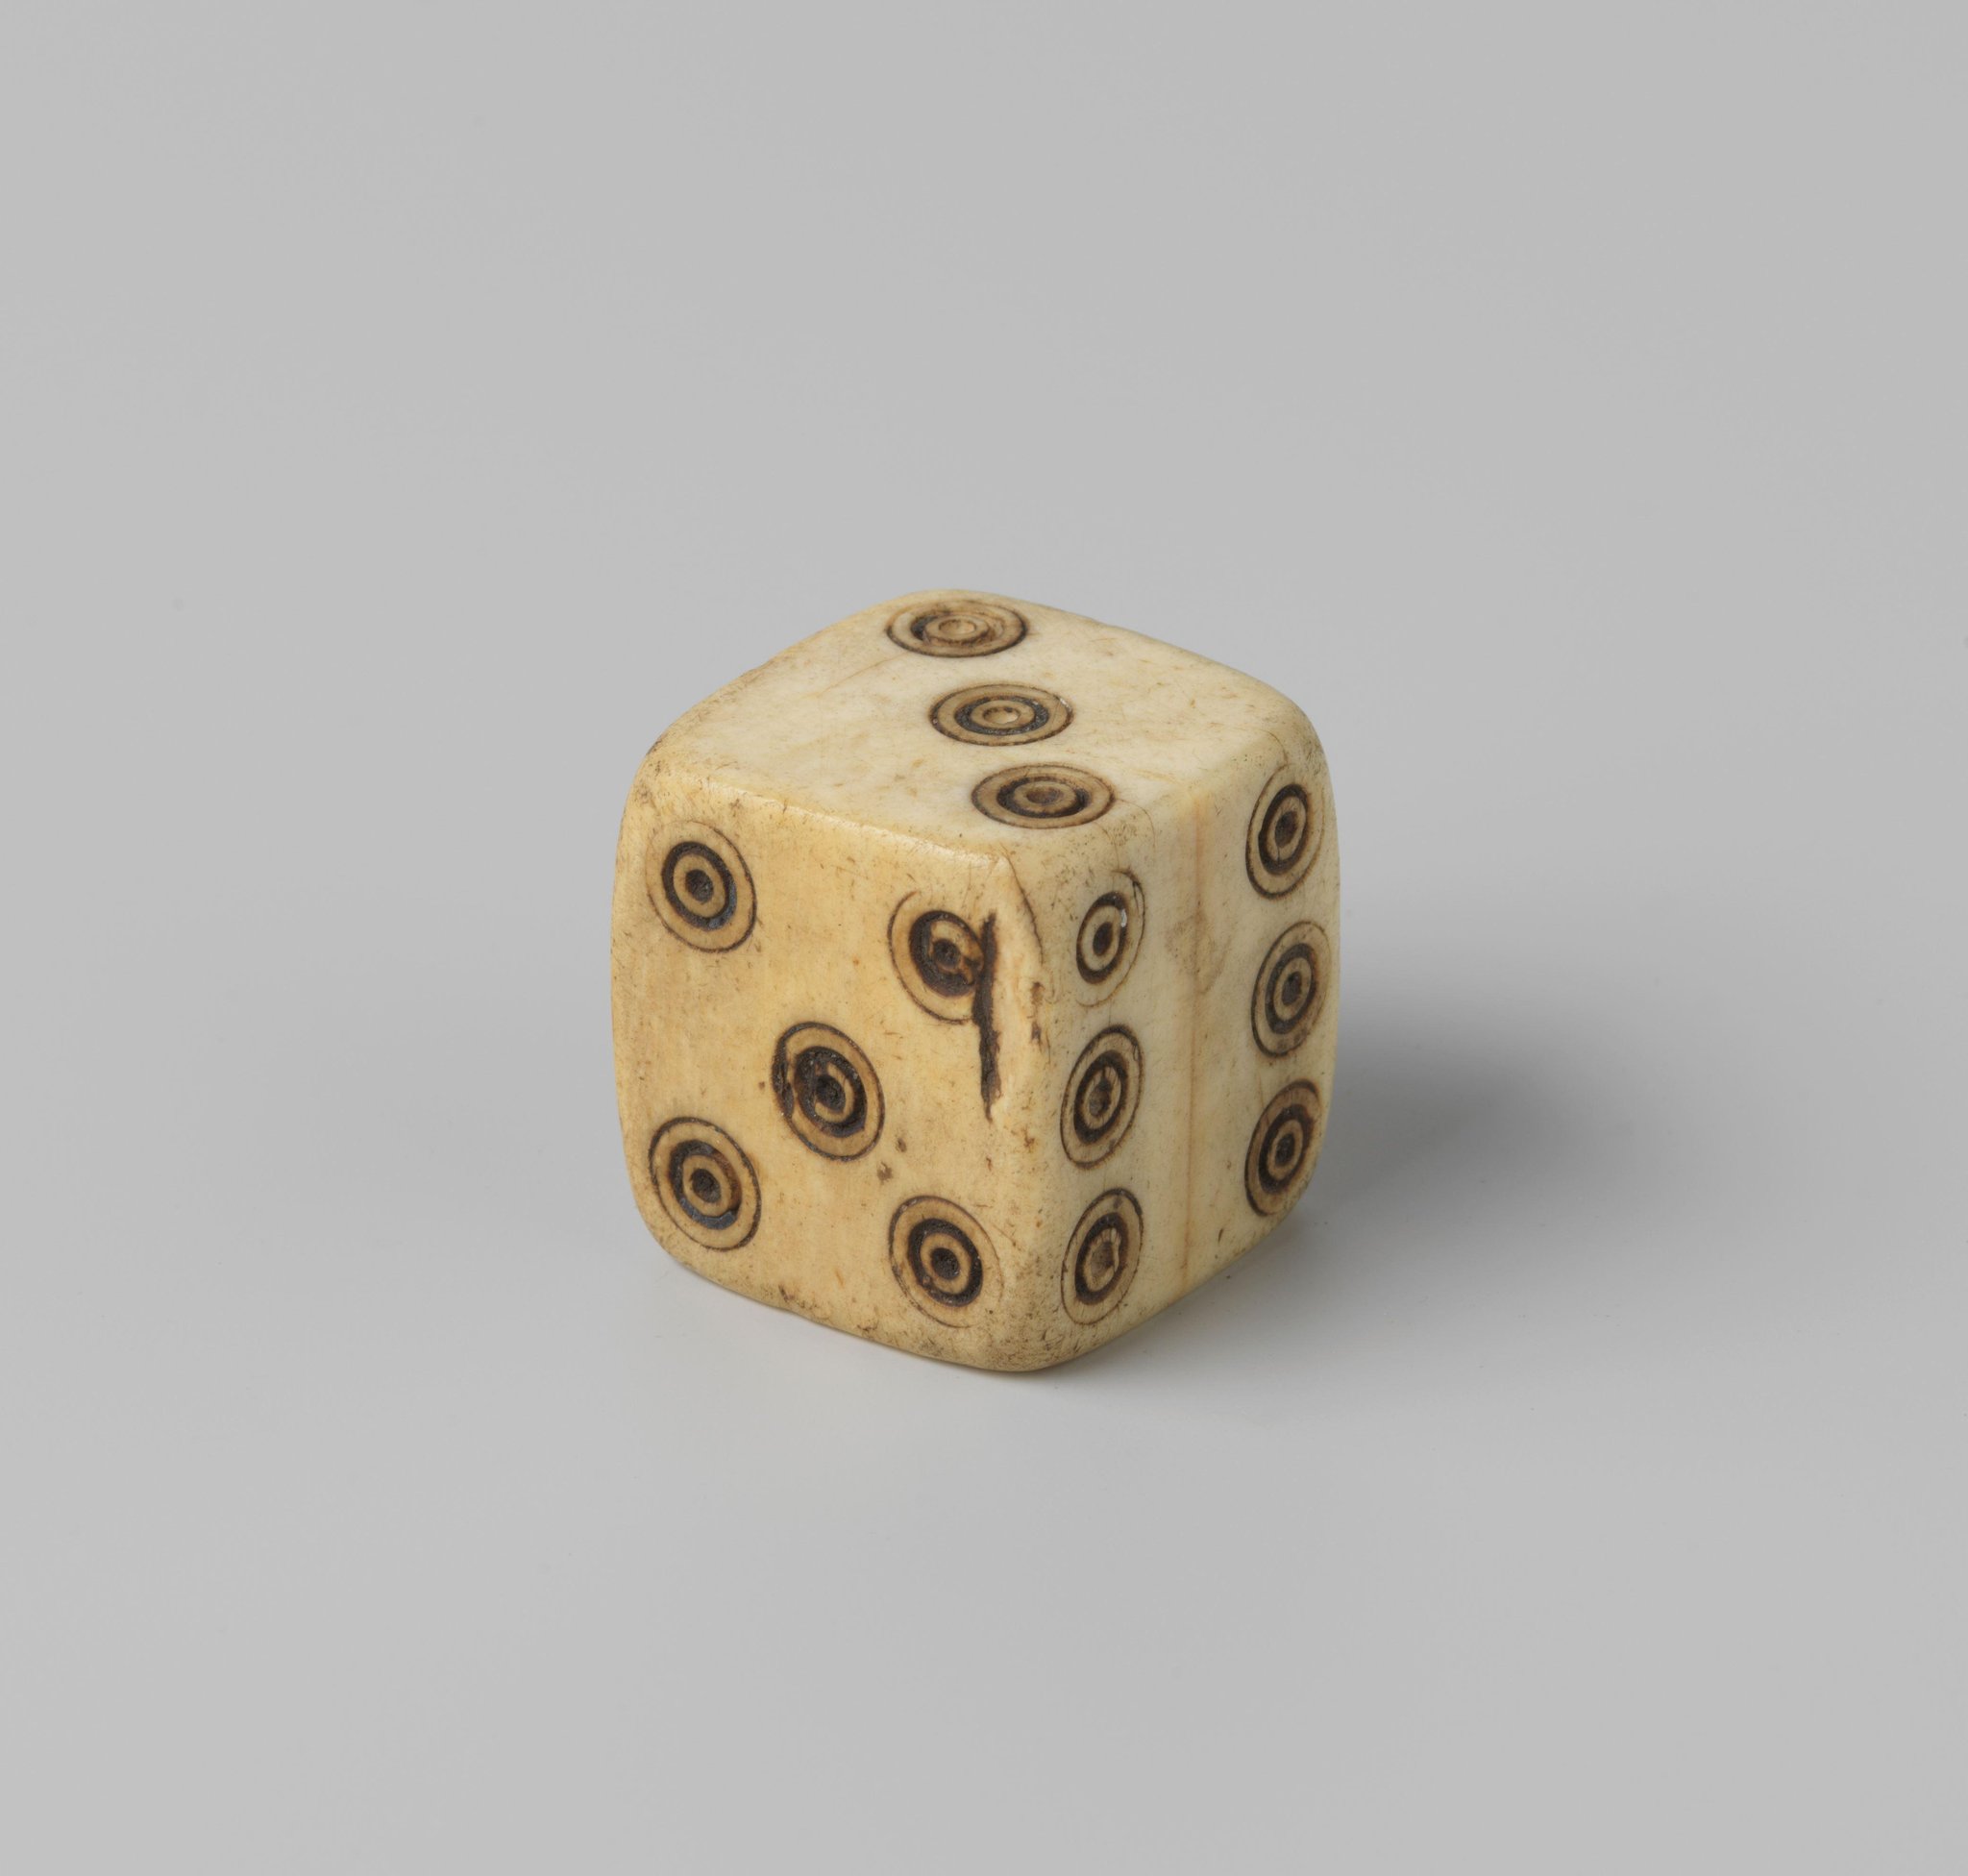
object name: die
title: Dobbelfiguur, drie stuks, waarvan twee een stel vormen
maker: Anonymous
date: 1600-1699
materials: ivory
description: Dobbelfiguur, drie stuks, van gesneden ivoor, waarvan twee een stel vormen. Opmerking: zwart aangeslagen.